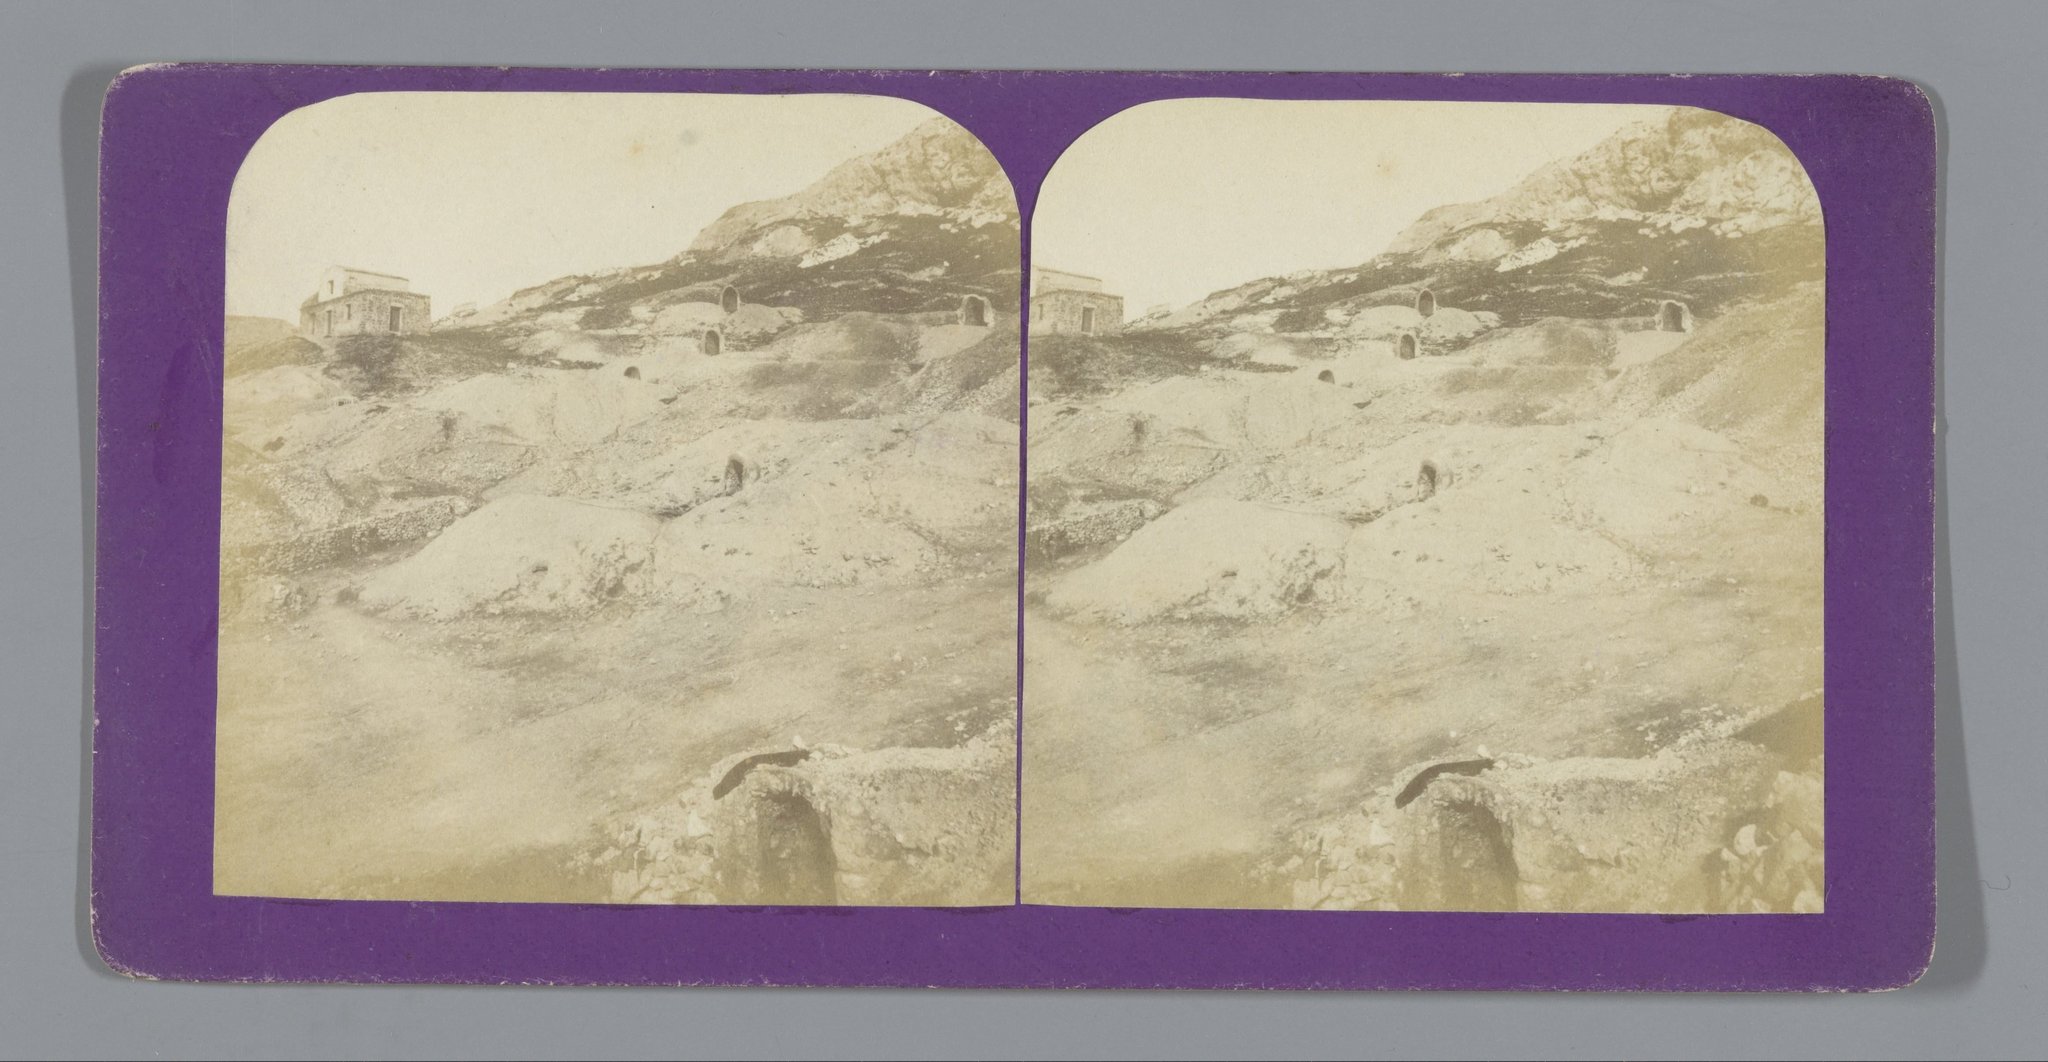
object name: stereograph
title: Gezicht op de zwavelmijnen van Agrigento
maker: jean andrieu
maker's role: fotograaf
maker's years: 1816-1872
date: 1862-1876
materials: cardboard, paper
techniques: albumen print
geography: agrigento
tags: mining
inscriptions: title: ‘1314 Montagne de soufre (Girgenti)’